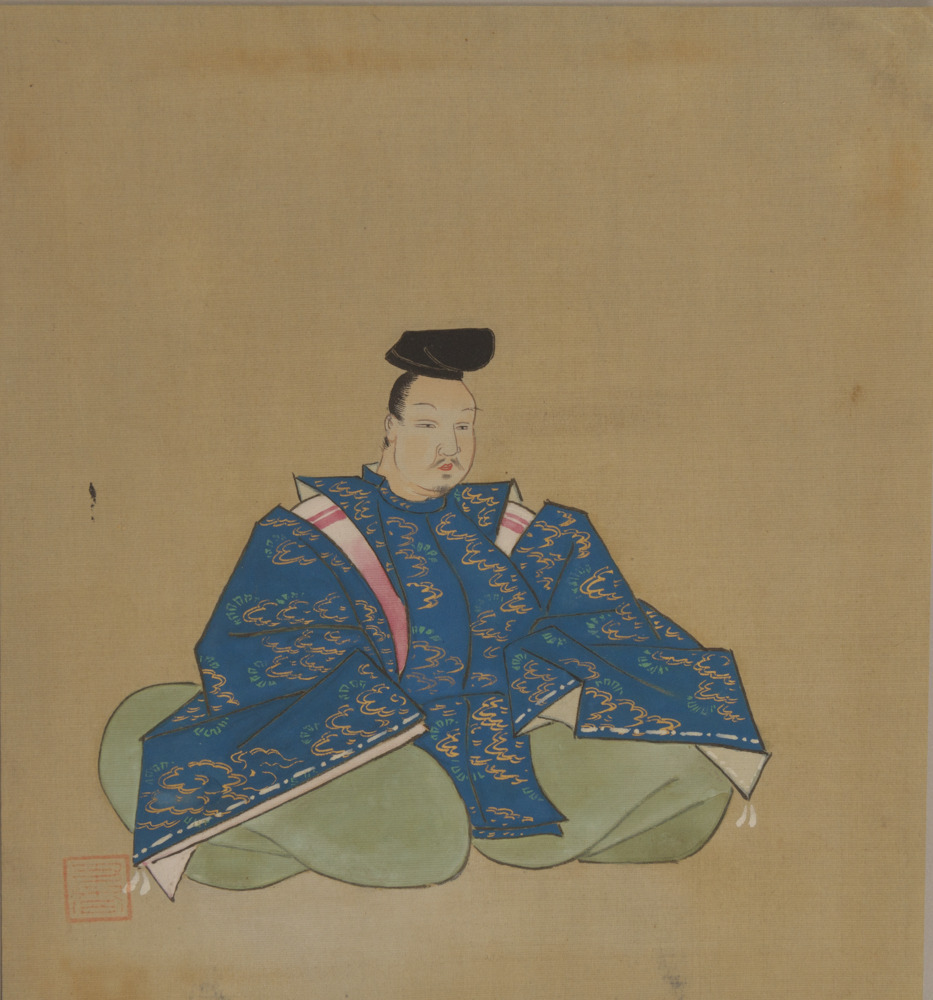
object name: painting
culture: japanese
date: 1914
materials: silk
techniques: painting